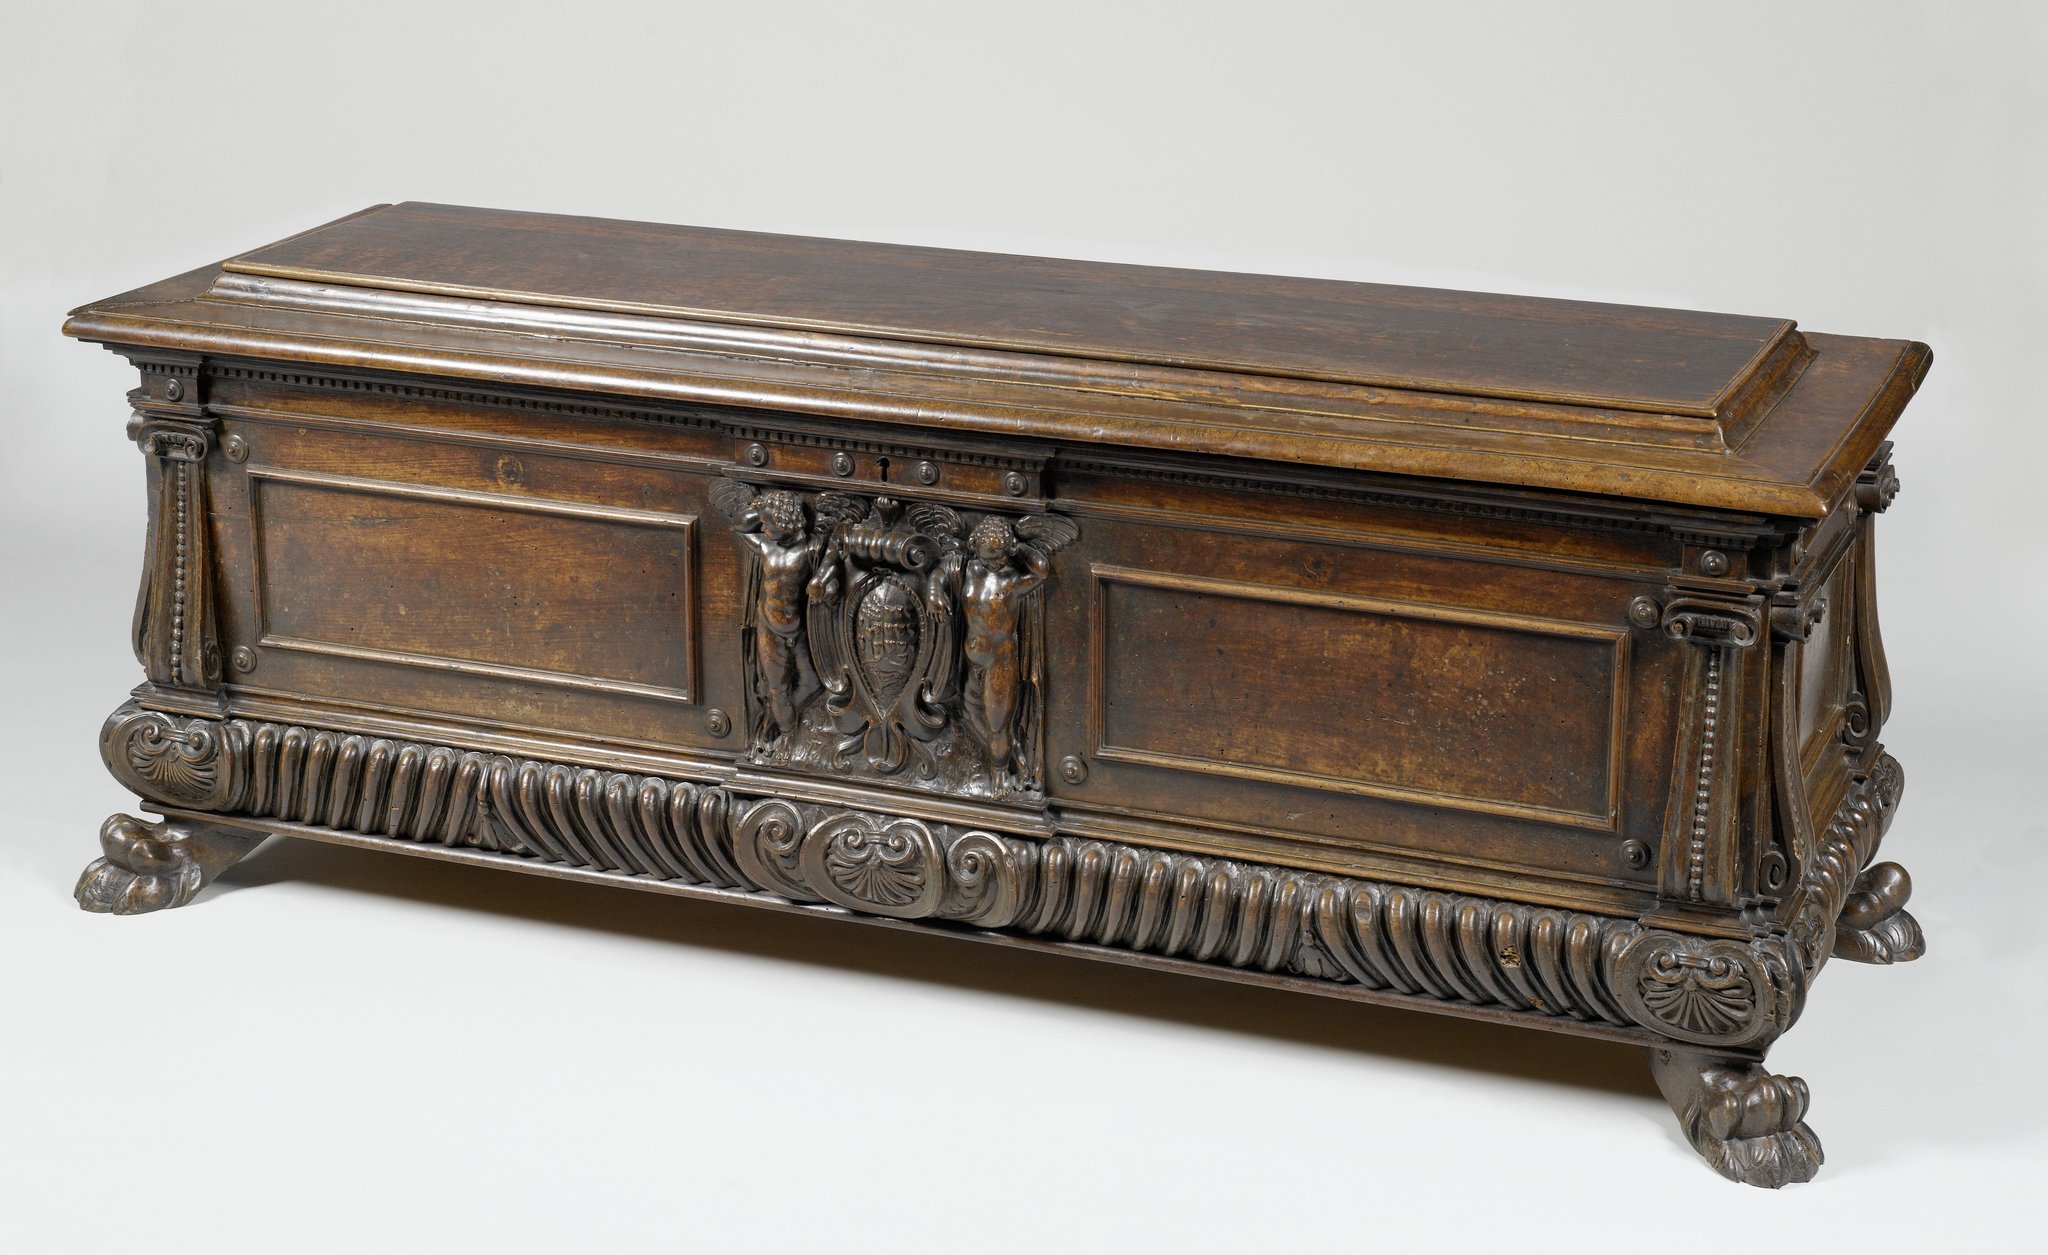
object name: chest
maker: Anonymous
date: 1550-1599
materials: wood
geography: italy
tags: cupids: 'amores', 'amoretti', 'putti'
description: Cassoni – chests used for storing expensive fabrics – had an important representational function. Owners could use them to show off their wealth and social standing. This was why such chests were often decorated with the family coat of arms. It is not known which family’s arms are depicted on this chest.